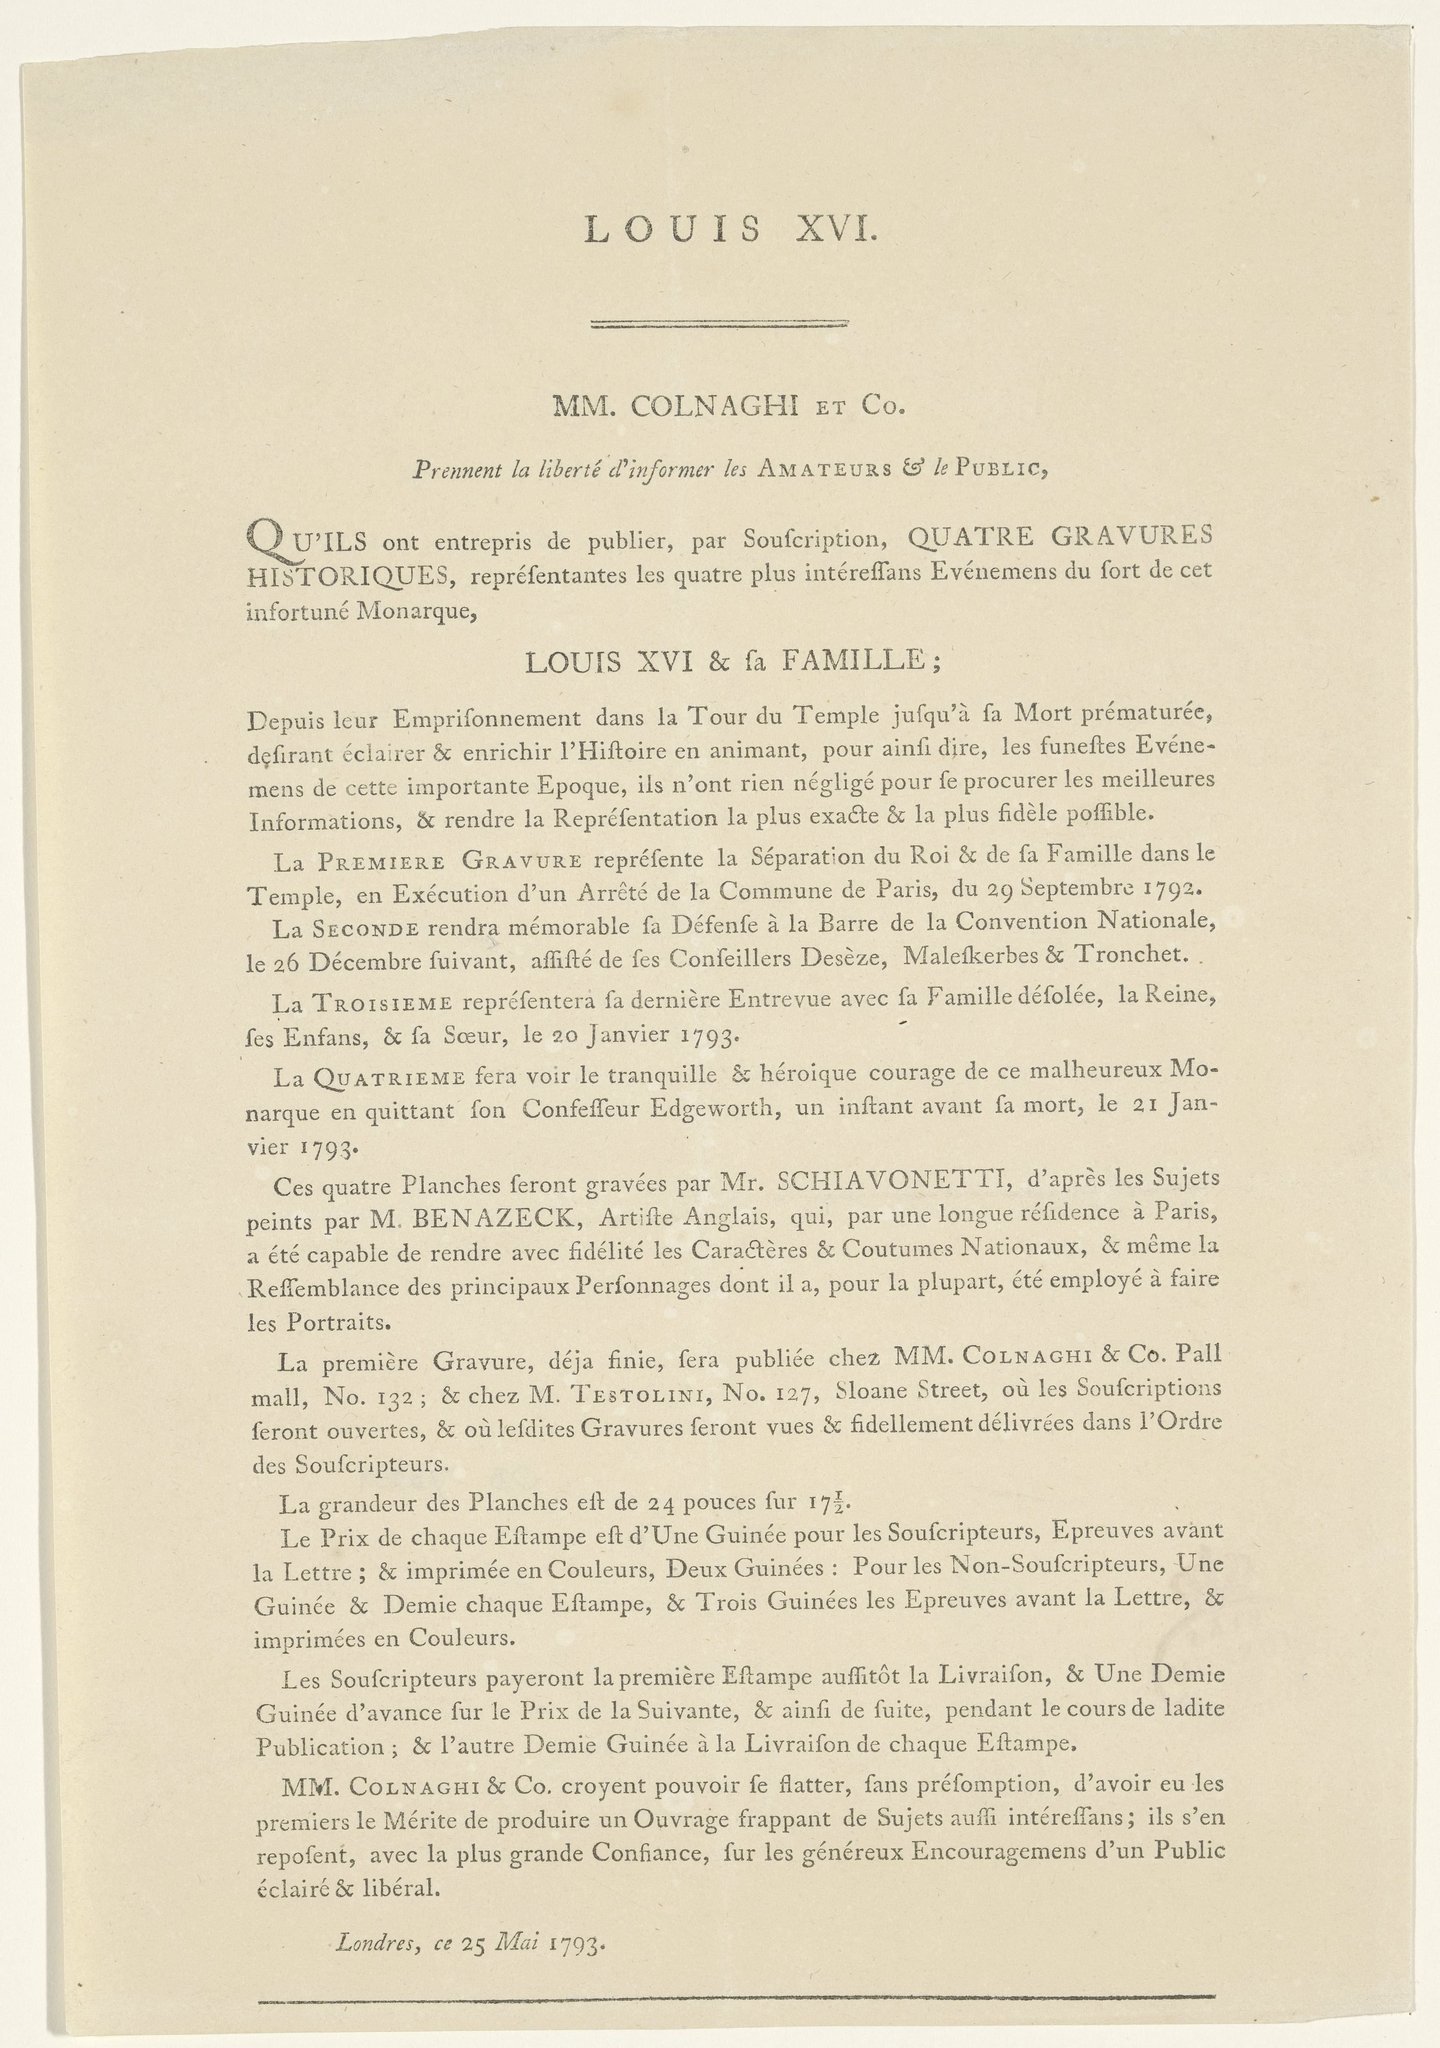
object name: uitgeversprospectus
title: Aankondiging van de prentreeks over de laatste dagen van Lodewijk XVI door Luigi Schiavonetti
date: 1793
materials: paper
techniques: letterpress printing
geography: london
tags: paris, lodewijk xvi (koning van frankrijk)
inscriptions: collector's mark: Lugt 12